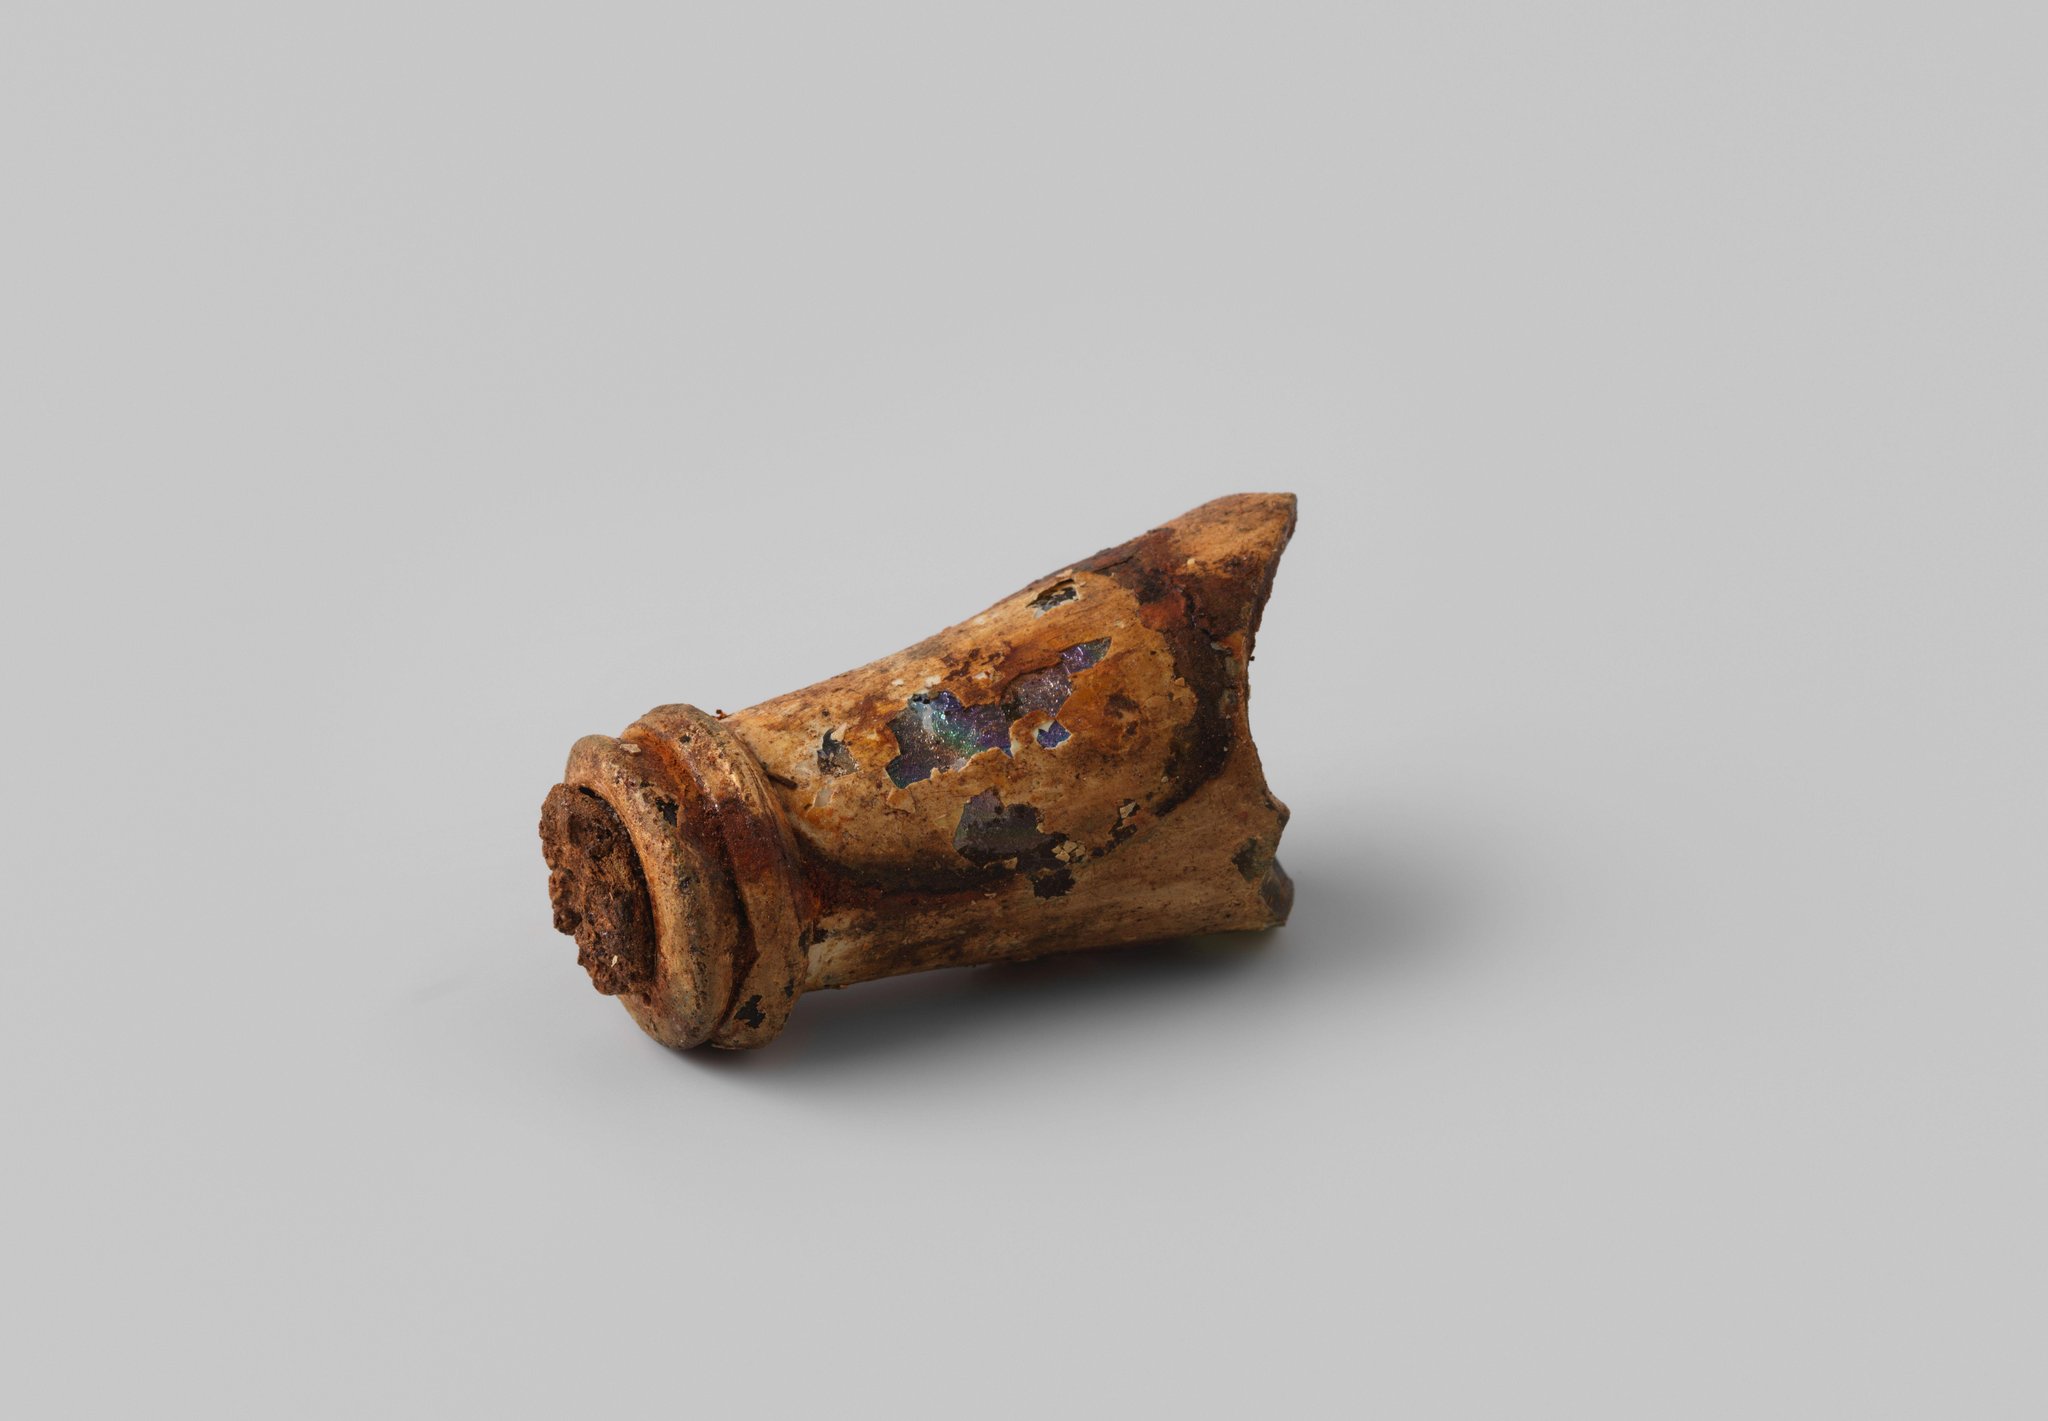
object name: neck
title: Hals met kurk van een wijnfles uit het wrak van de Oost-Indiëvaarder Hollandia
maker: Anonymous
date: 1700-1743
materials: glass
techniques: green glass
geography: netherlands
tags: verenigde oostindische compagnie, hollandia (schip), annet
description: Wine bottle, continental production, neck, onion-shaped bottle or bottle with vertical side; fragm, eroded, vs-string rim, projecting cork.